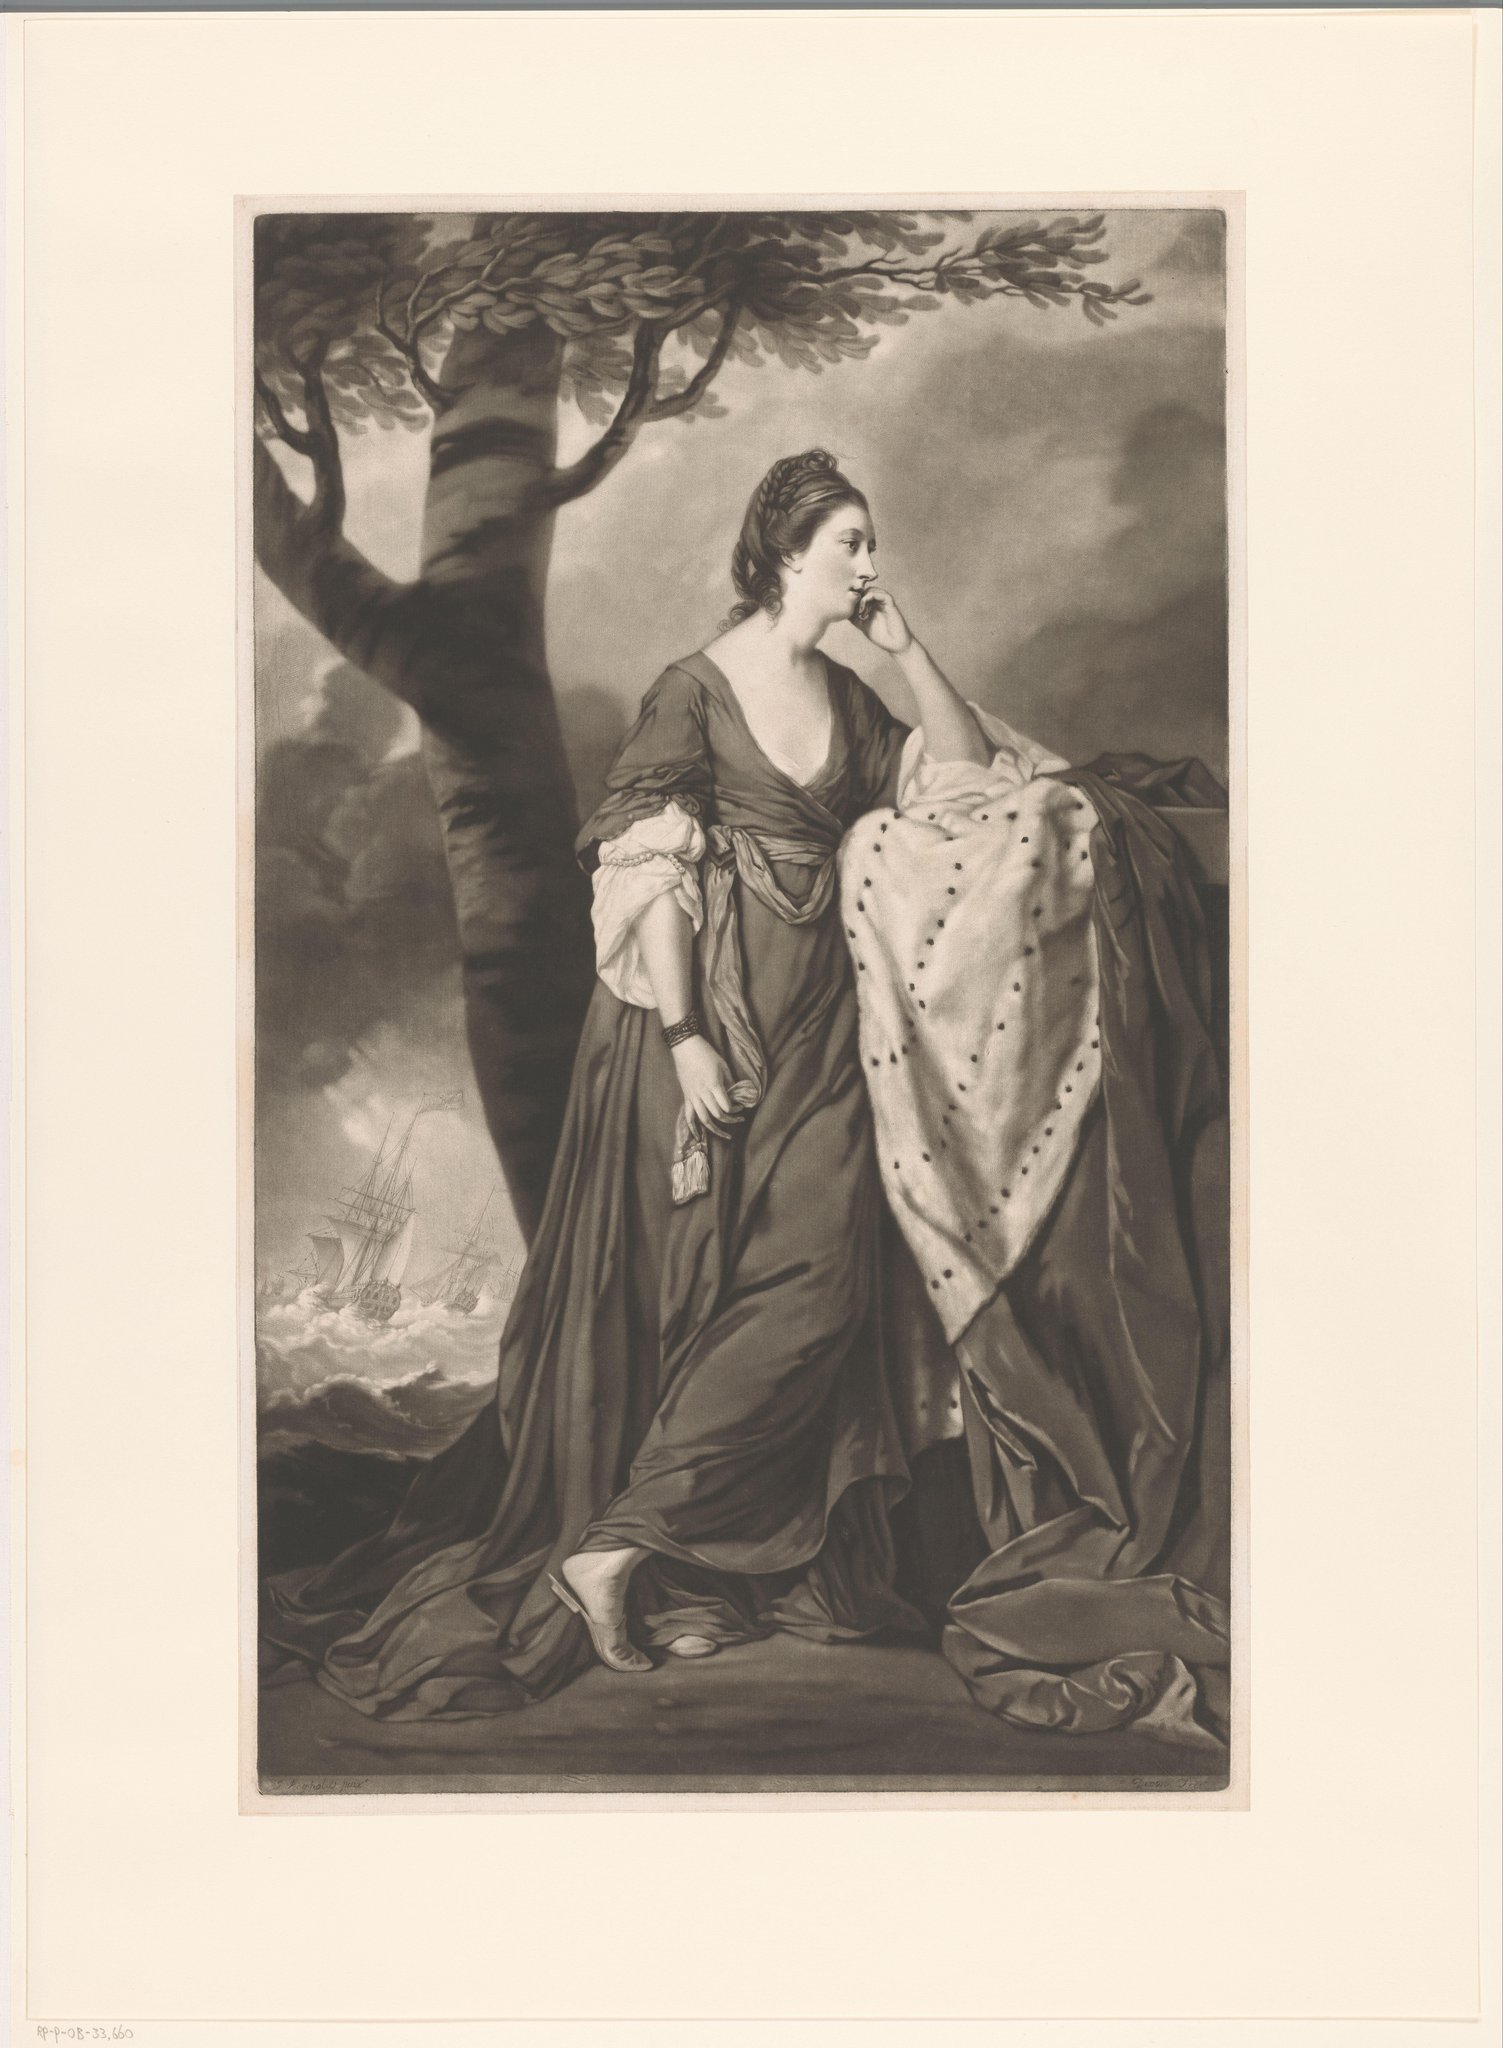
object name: print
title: Portret van Mary Bertie, hertogin van Ancaster en Kesteven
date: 1730-1811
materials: paper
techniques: engraving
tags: adolescent, young woman, maiden, historical persons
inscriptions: collector's mark: Lugt 240